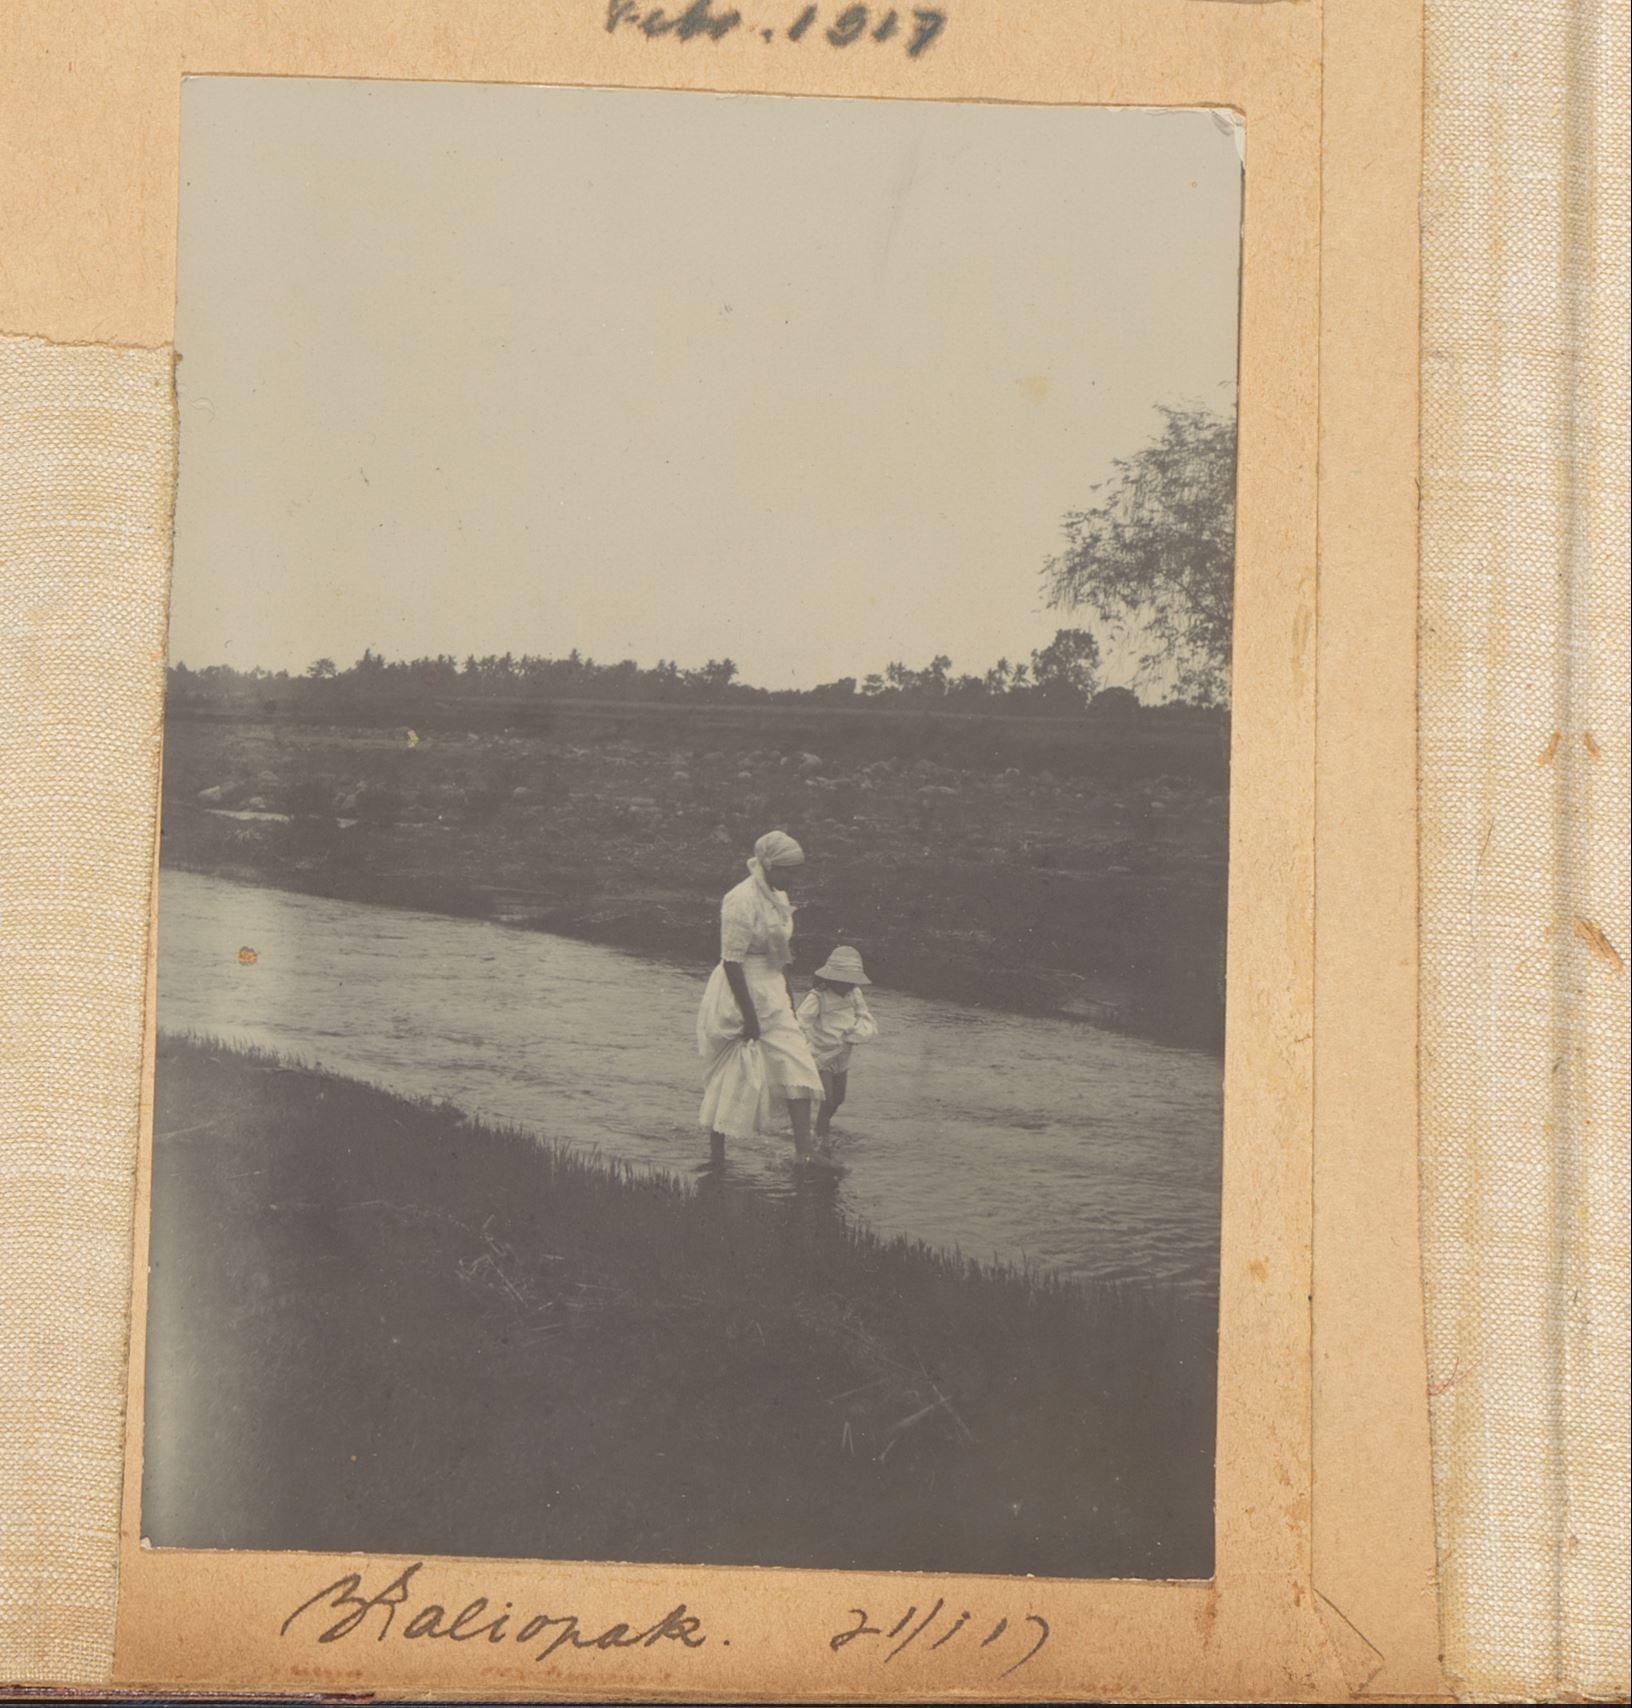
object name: photograph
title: Vrouw met kind wadend door Kali Opak op Java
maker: Anonymous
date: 1917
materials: photographic support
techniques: daylight paper print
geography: java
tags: brook, mother and baby or young child, java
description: Onderdeel van Familiealbum met foto's van een familie in de voormalige kolonie Nederlands-Indië en van een suikerfabriek in Purworejo.